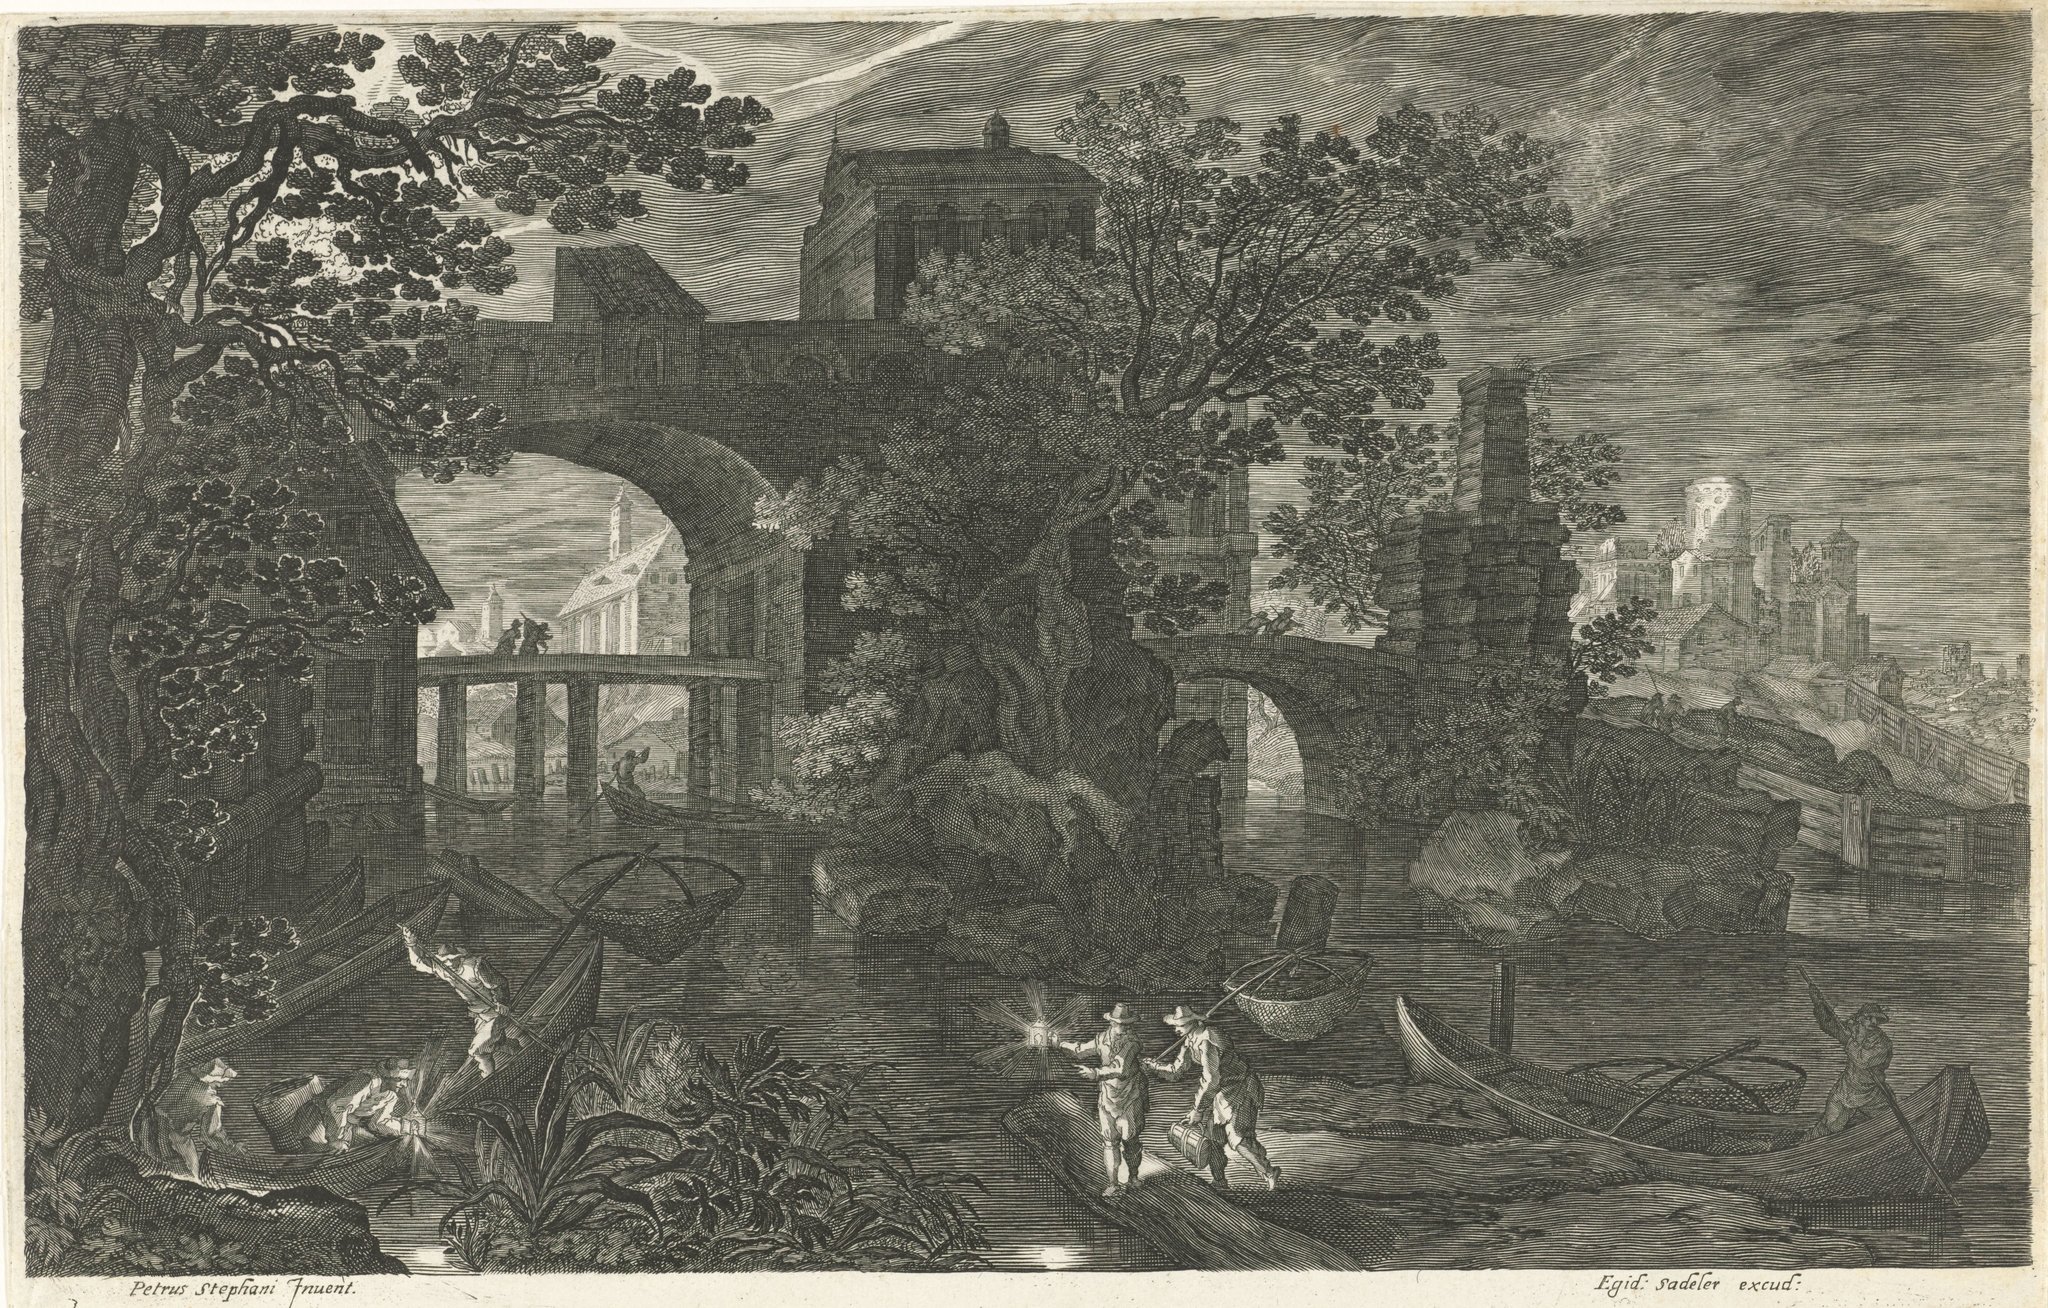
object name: print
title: Nachtelijk tafereel met vissers op een rivier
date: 1597-1629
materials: paper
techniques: engraving, etching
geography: prague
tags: commercial fishery, bridge in city across river, canal, etc. (+ city(-scape) with figures, staffage), night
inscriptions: collector's mark: Lugt 240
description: Vissers met bootjes bevaren een rivier in de nacht. Op de achtergrond een brug. De vijfde prent van een achtdelige reeks met landschappen in Bohemen